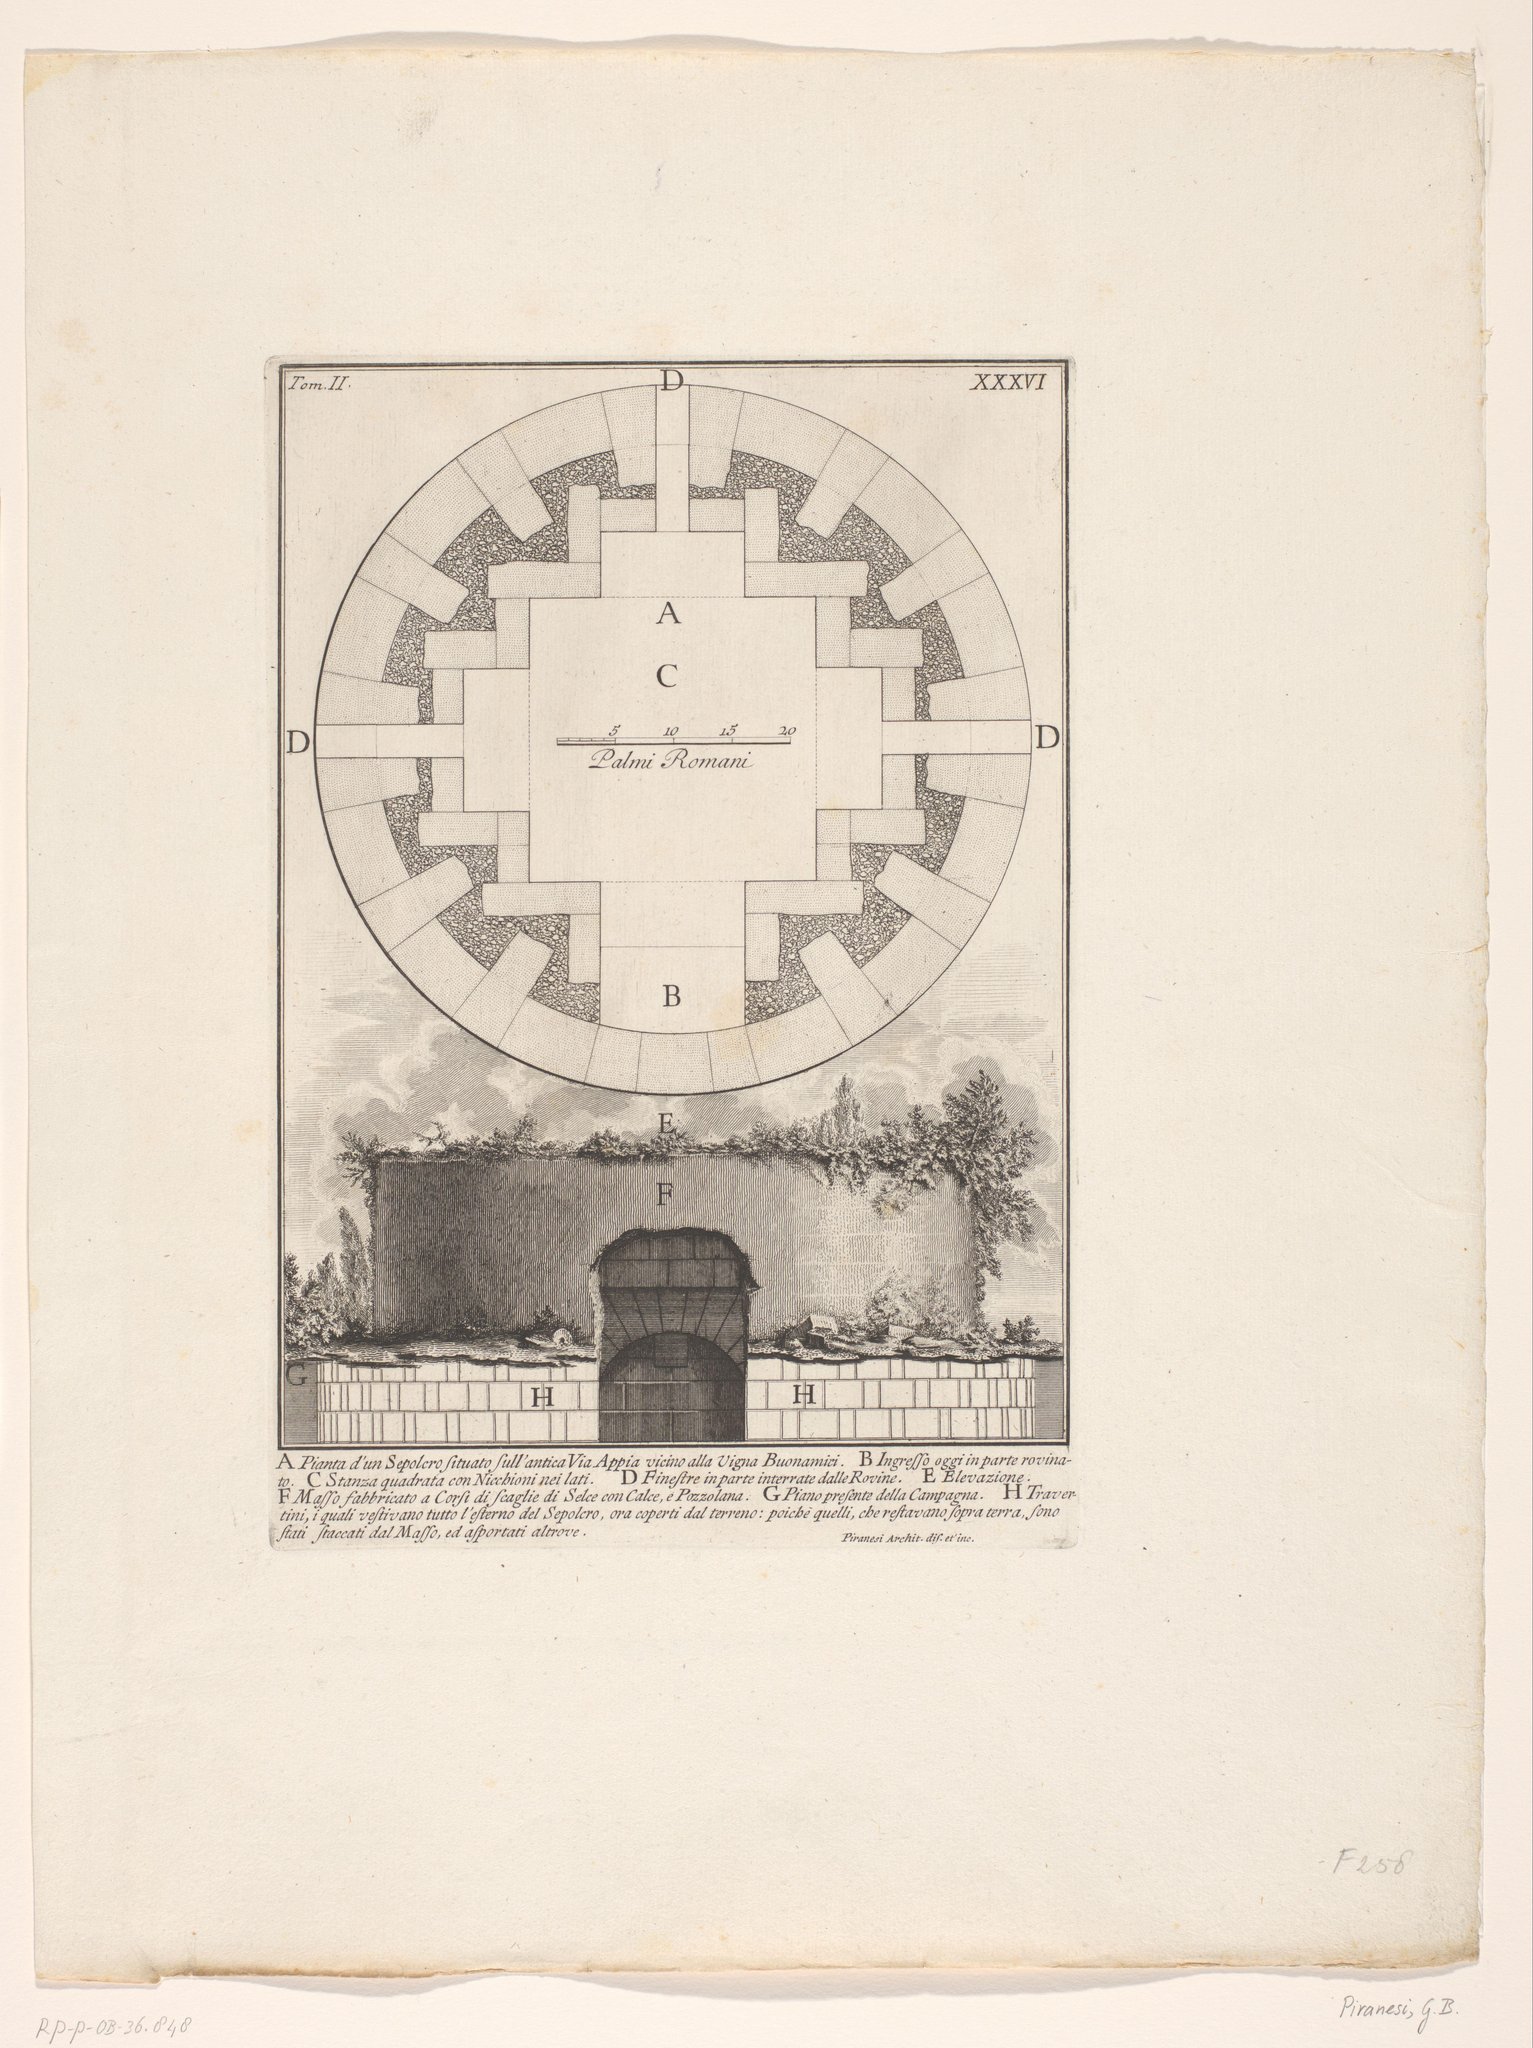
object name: print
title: Graftombe aan de Via Appia Antica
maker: giovanni battista piranesi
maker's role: designer, draughtsman, print maker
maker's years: 1720-1778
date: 1756-1757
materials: paper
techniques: etching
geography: rome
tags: ruin of a building ~ architecture, grave, tomb, plan ~ architecture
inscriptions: collector's mark: Lugt 2228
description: Deze prent maakt deel uit van de serie 'Le Antichità Romane'. Piranesi deed meer dan acht jaar voorstudie voor deze 250 platen tellende serie die in vier volumes werd uitgegeven. Hij produceerde de prenten tussen ca. 1756 en 1757. De serie bevat ook prenten door of naar andere prentmakers, onder wie Francesco Bianchini en Girolamo Rossi.